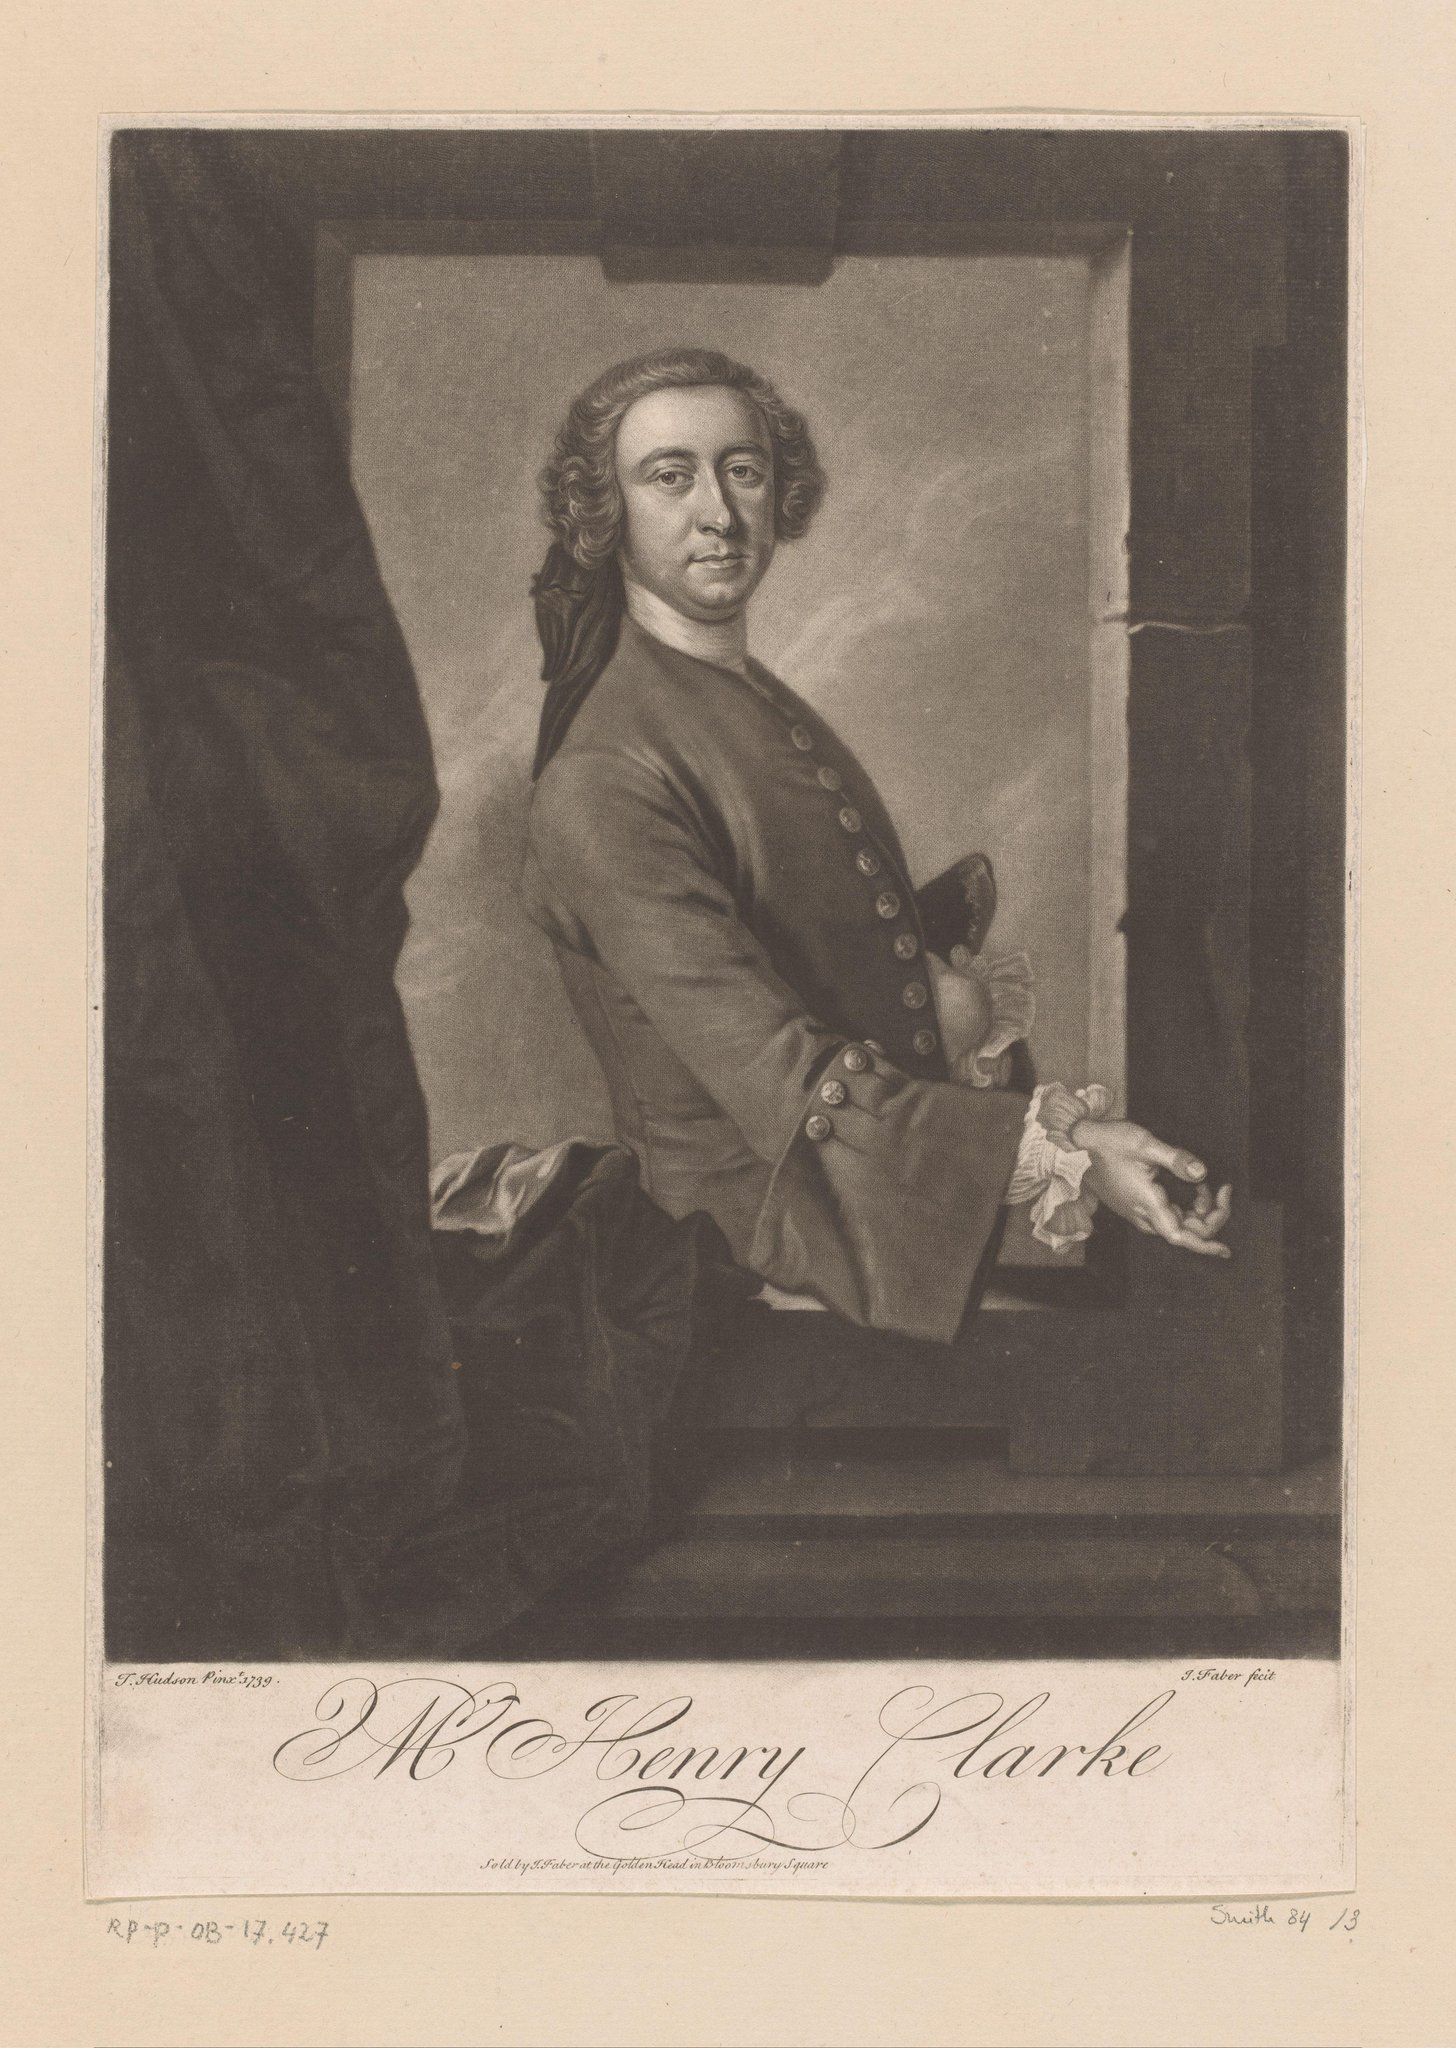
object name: print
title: Portret van Henry Clarke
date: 1739-1756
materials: paper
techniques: etching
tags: historical persons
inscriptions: collector's mark: Lugt 240